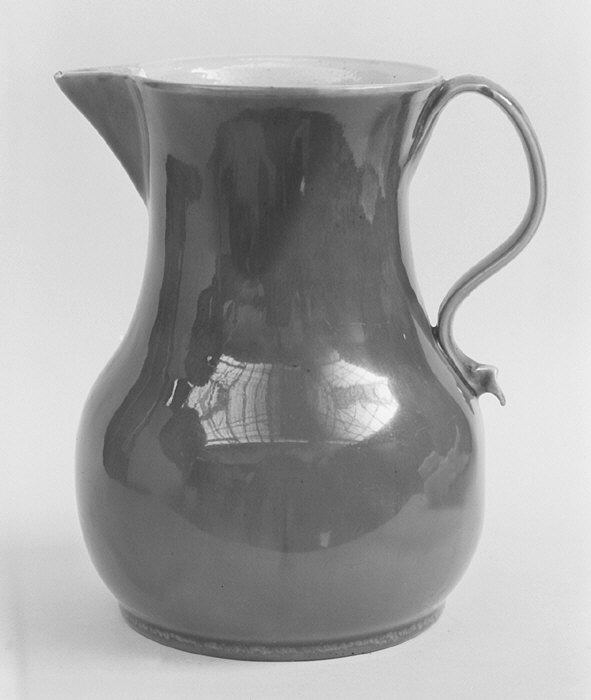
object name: jug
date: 1755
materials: stoneware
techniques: salt glaze